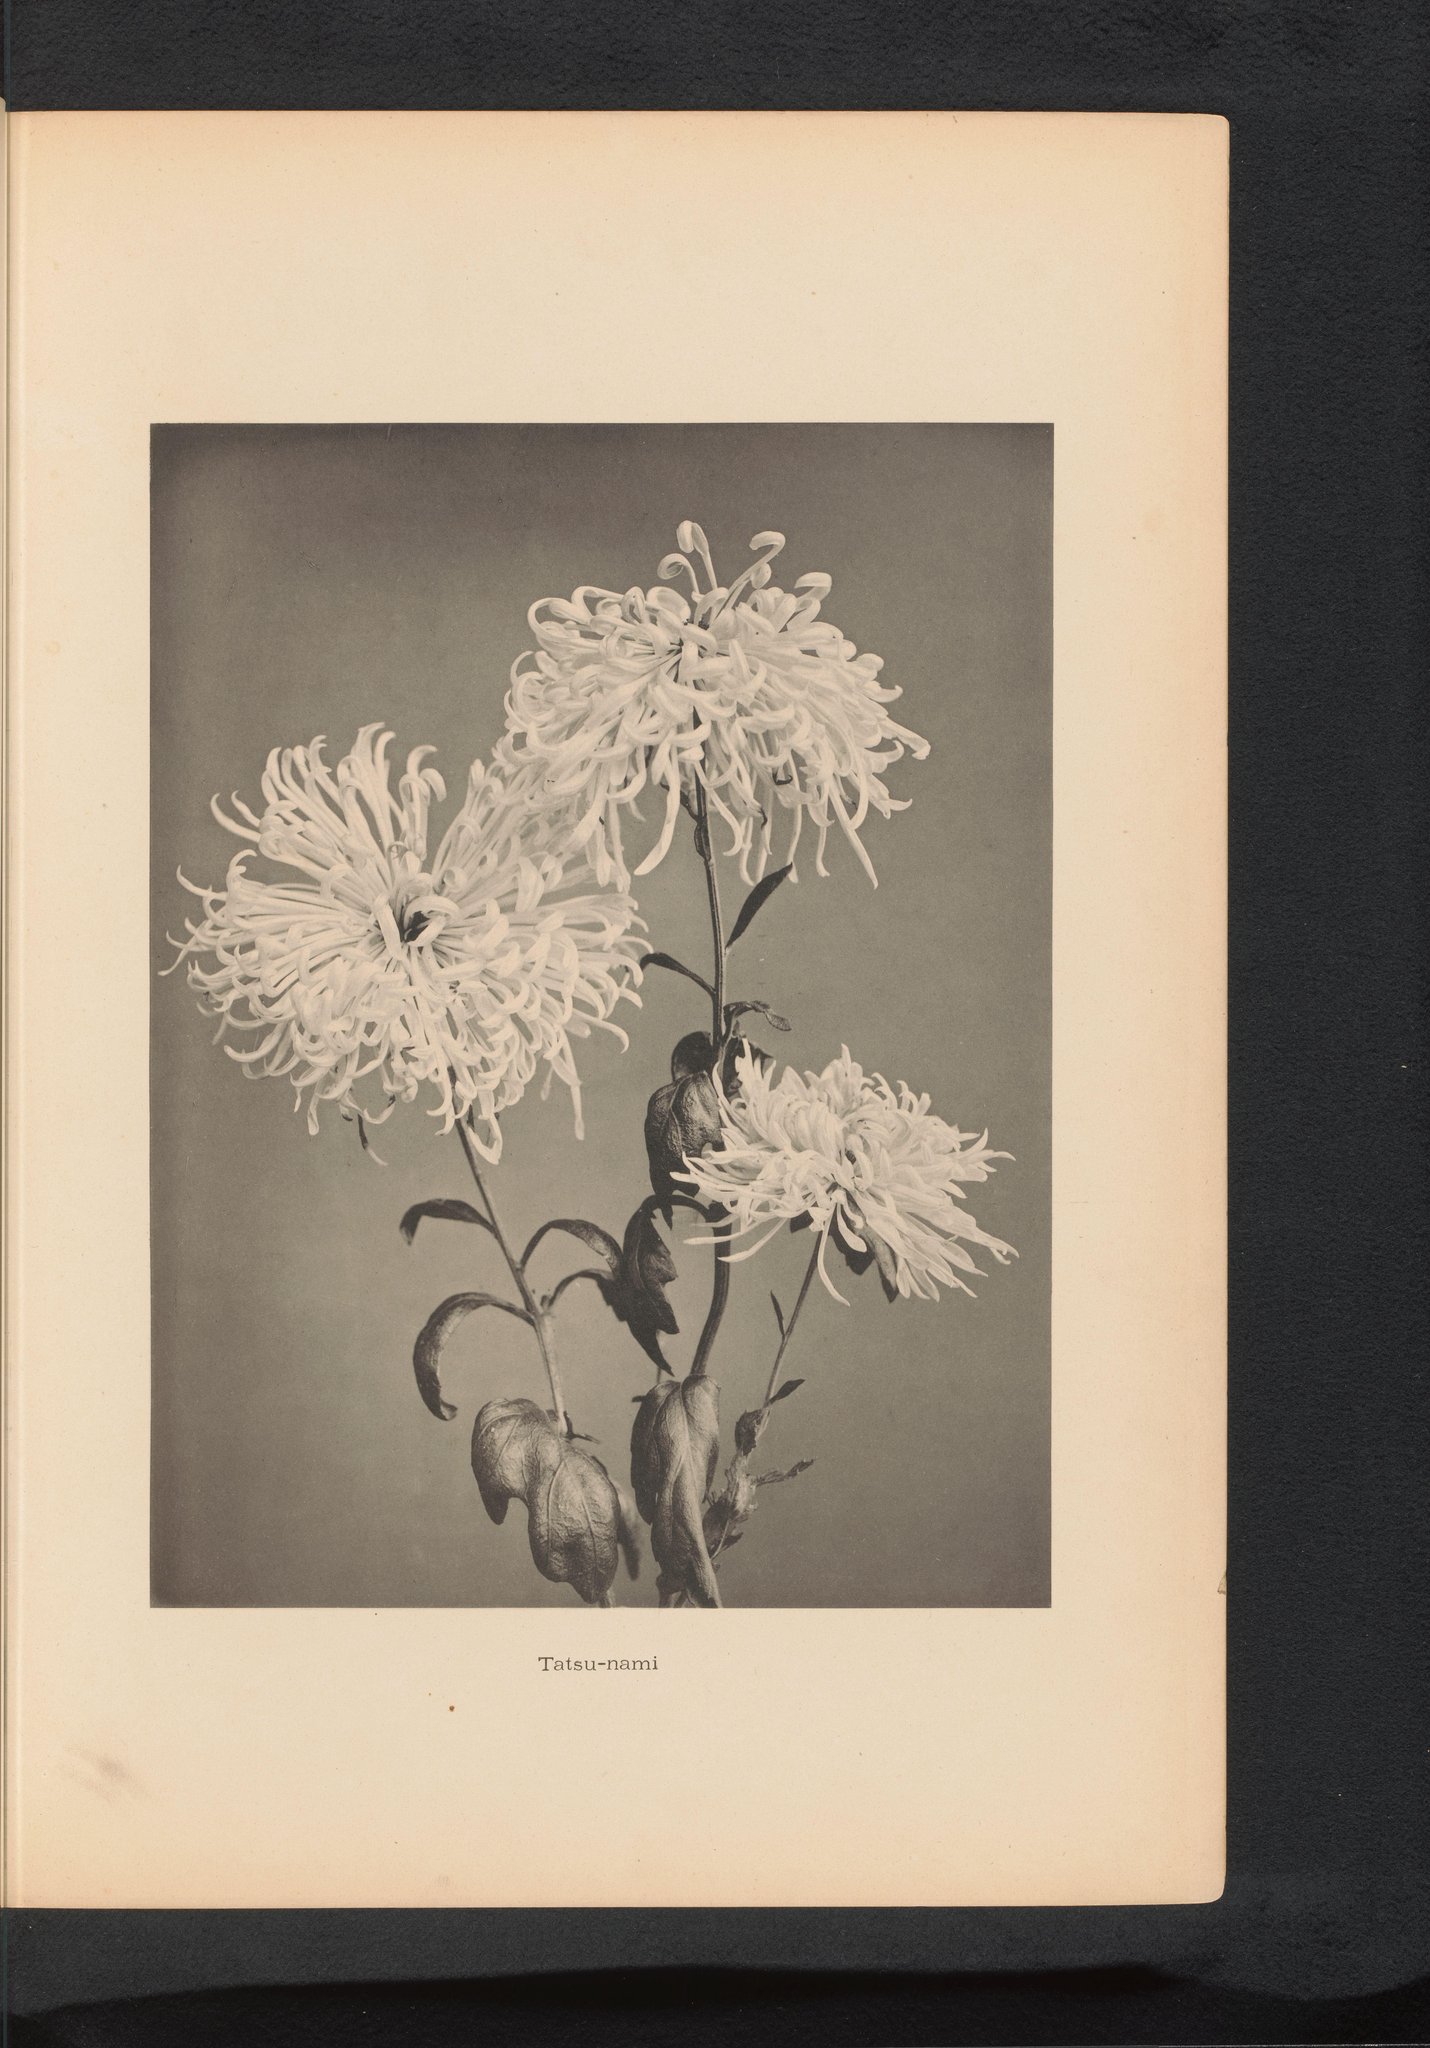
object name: photomechanical print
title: Chrysant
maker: kazumasa ogawa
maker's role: auteur, fotograaf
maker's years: 1860-1929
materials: paper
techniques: photograph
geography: tokyo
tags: flowers: chrysanthemum, japan